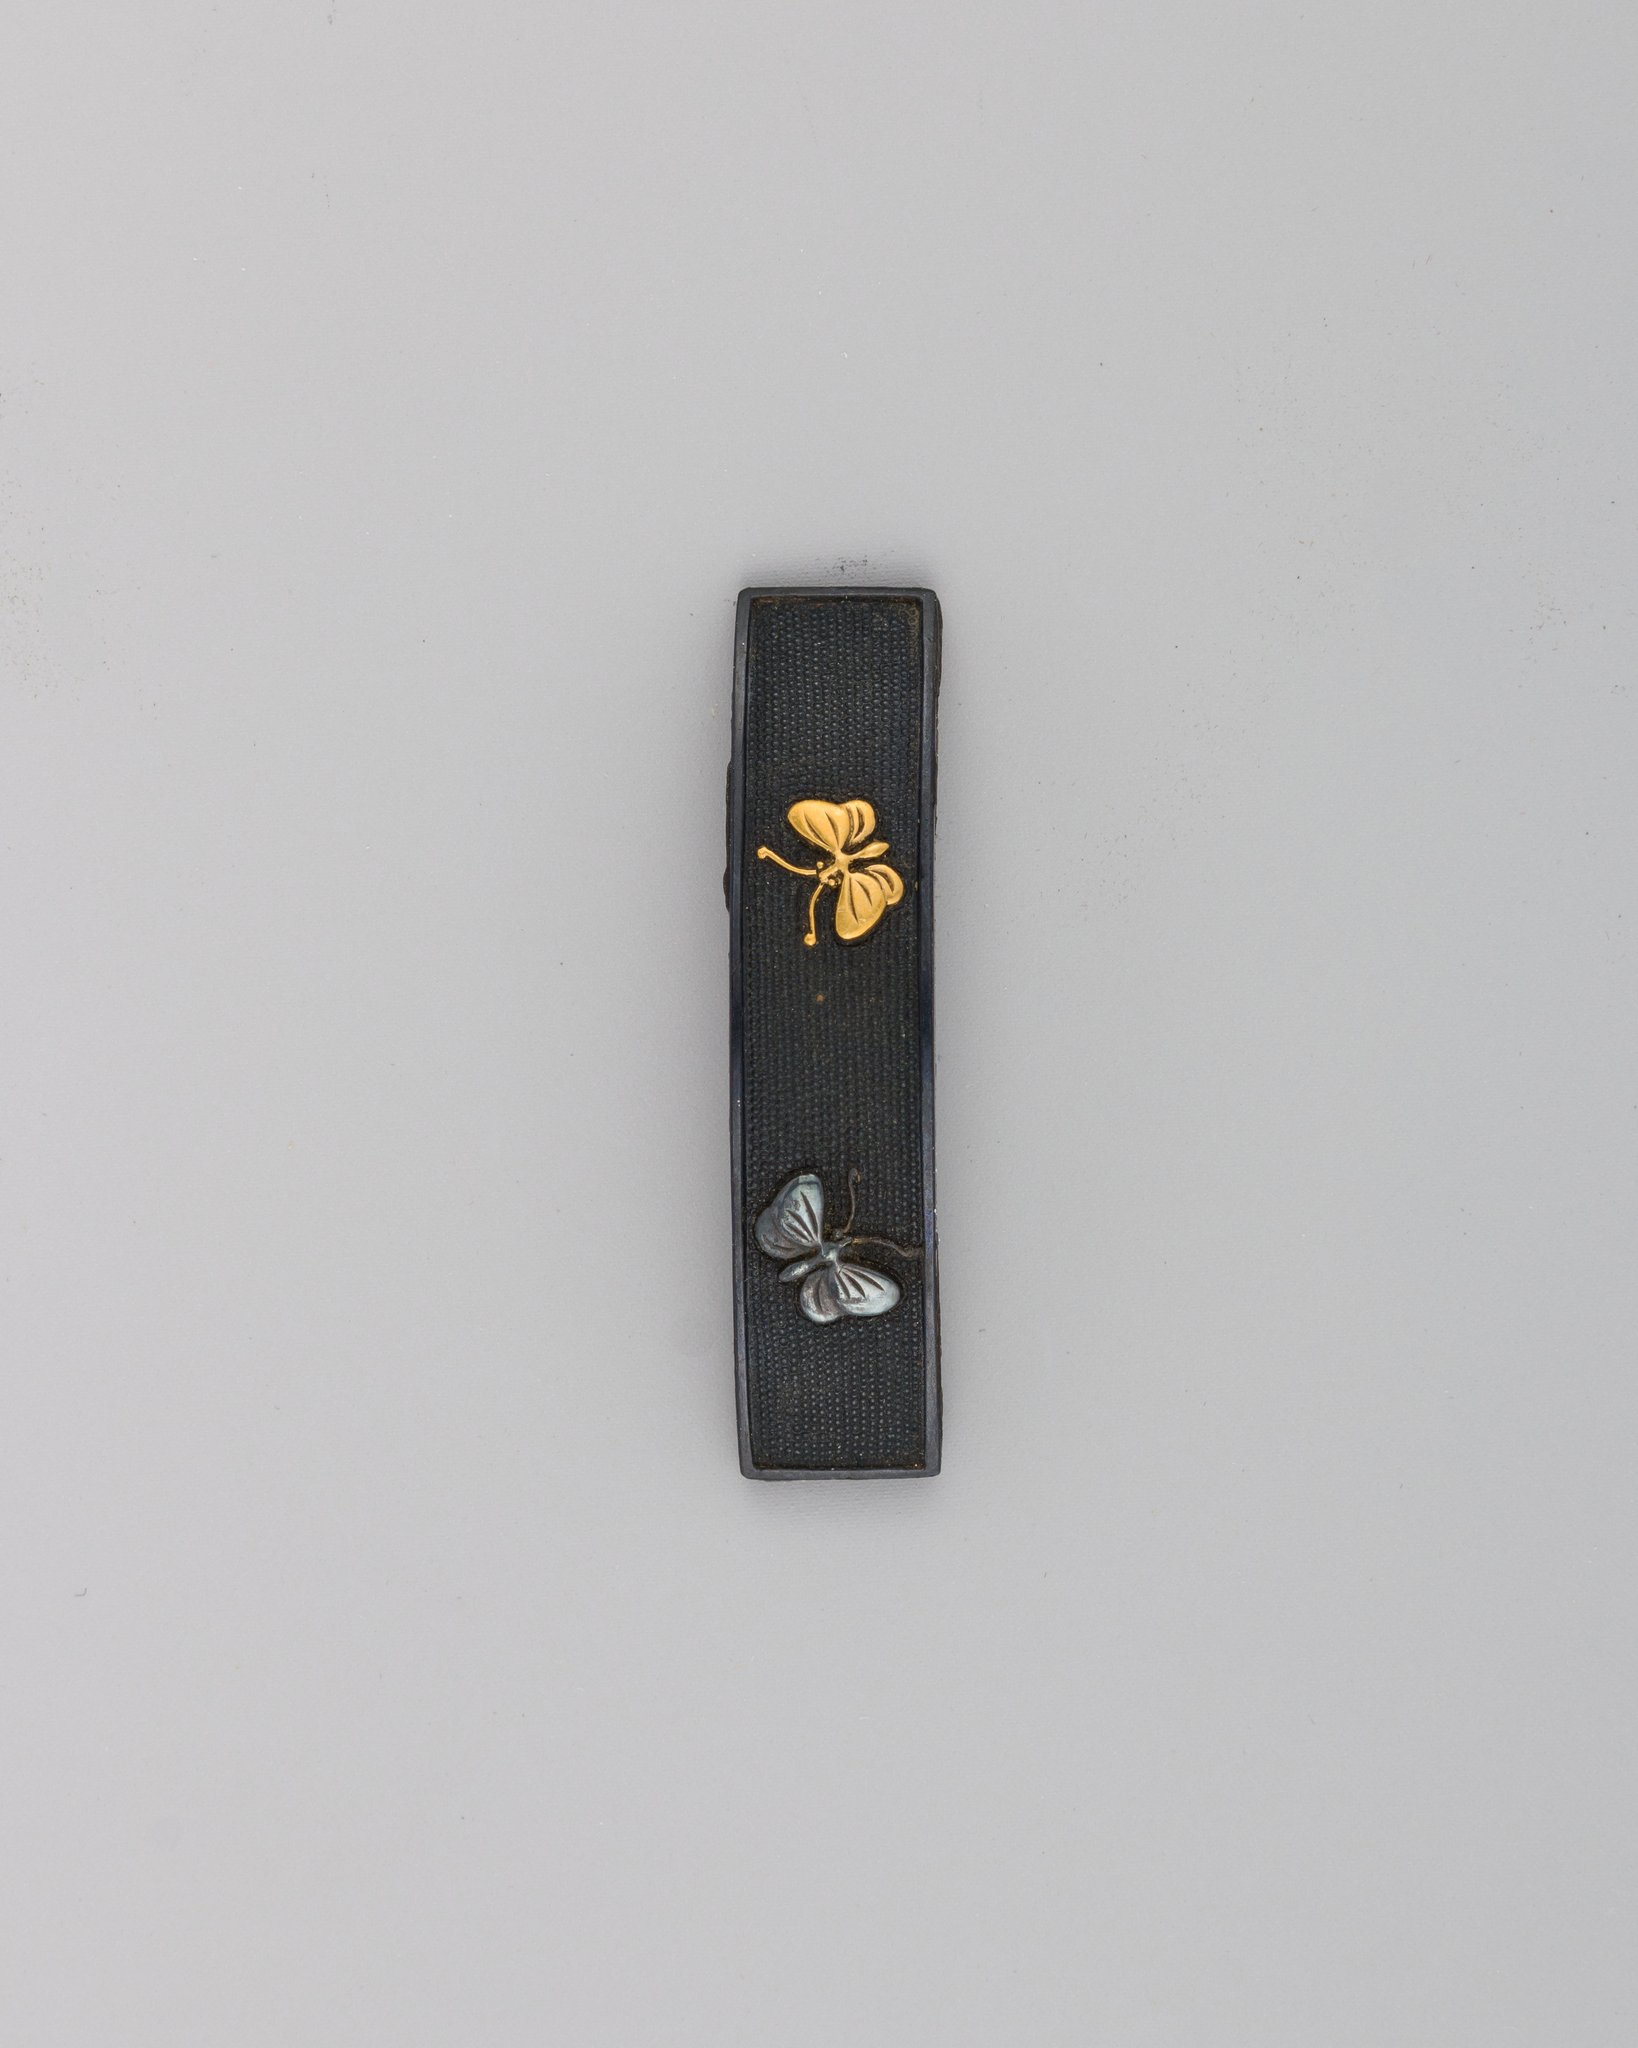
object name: socket brace for knife uragawara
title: Socket Brace for Knife (Uragawara)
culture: japanese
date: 1801-1900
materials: gold alloy, gold, silver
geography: japan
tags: butterflies